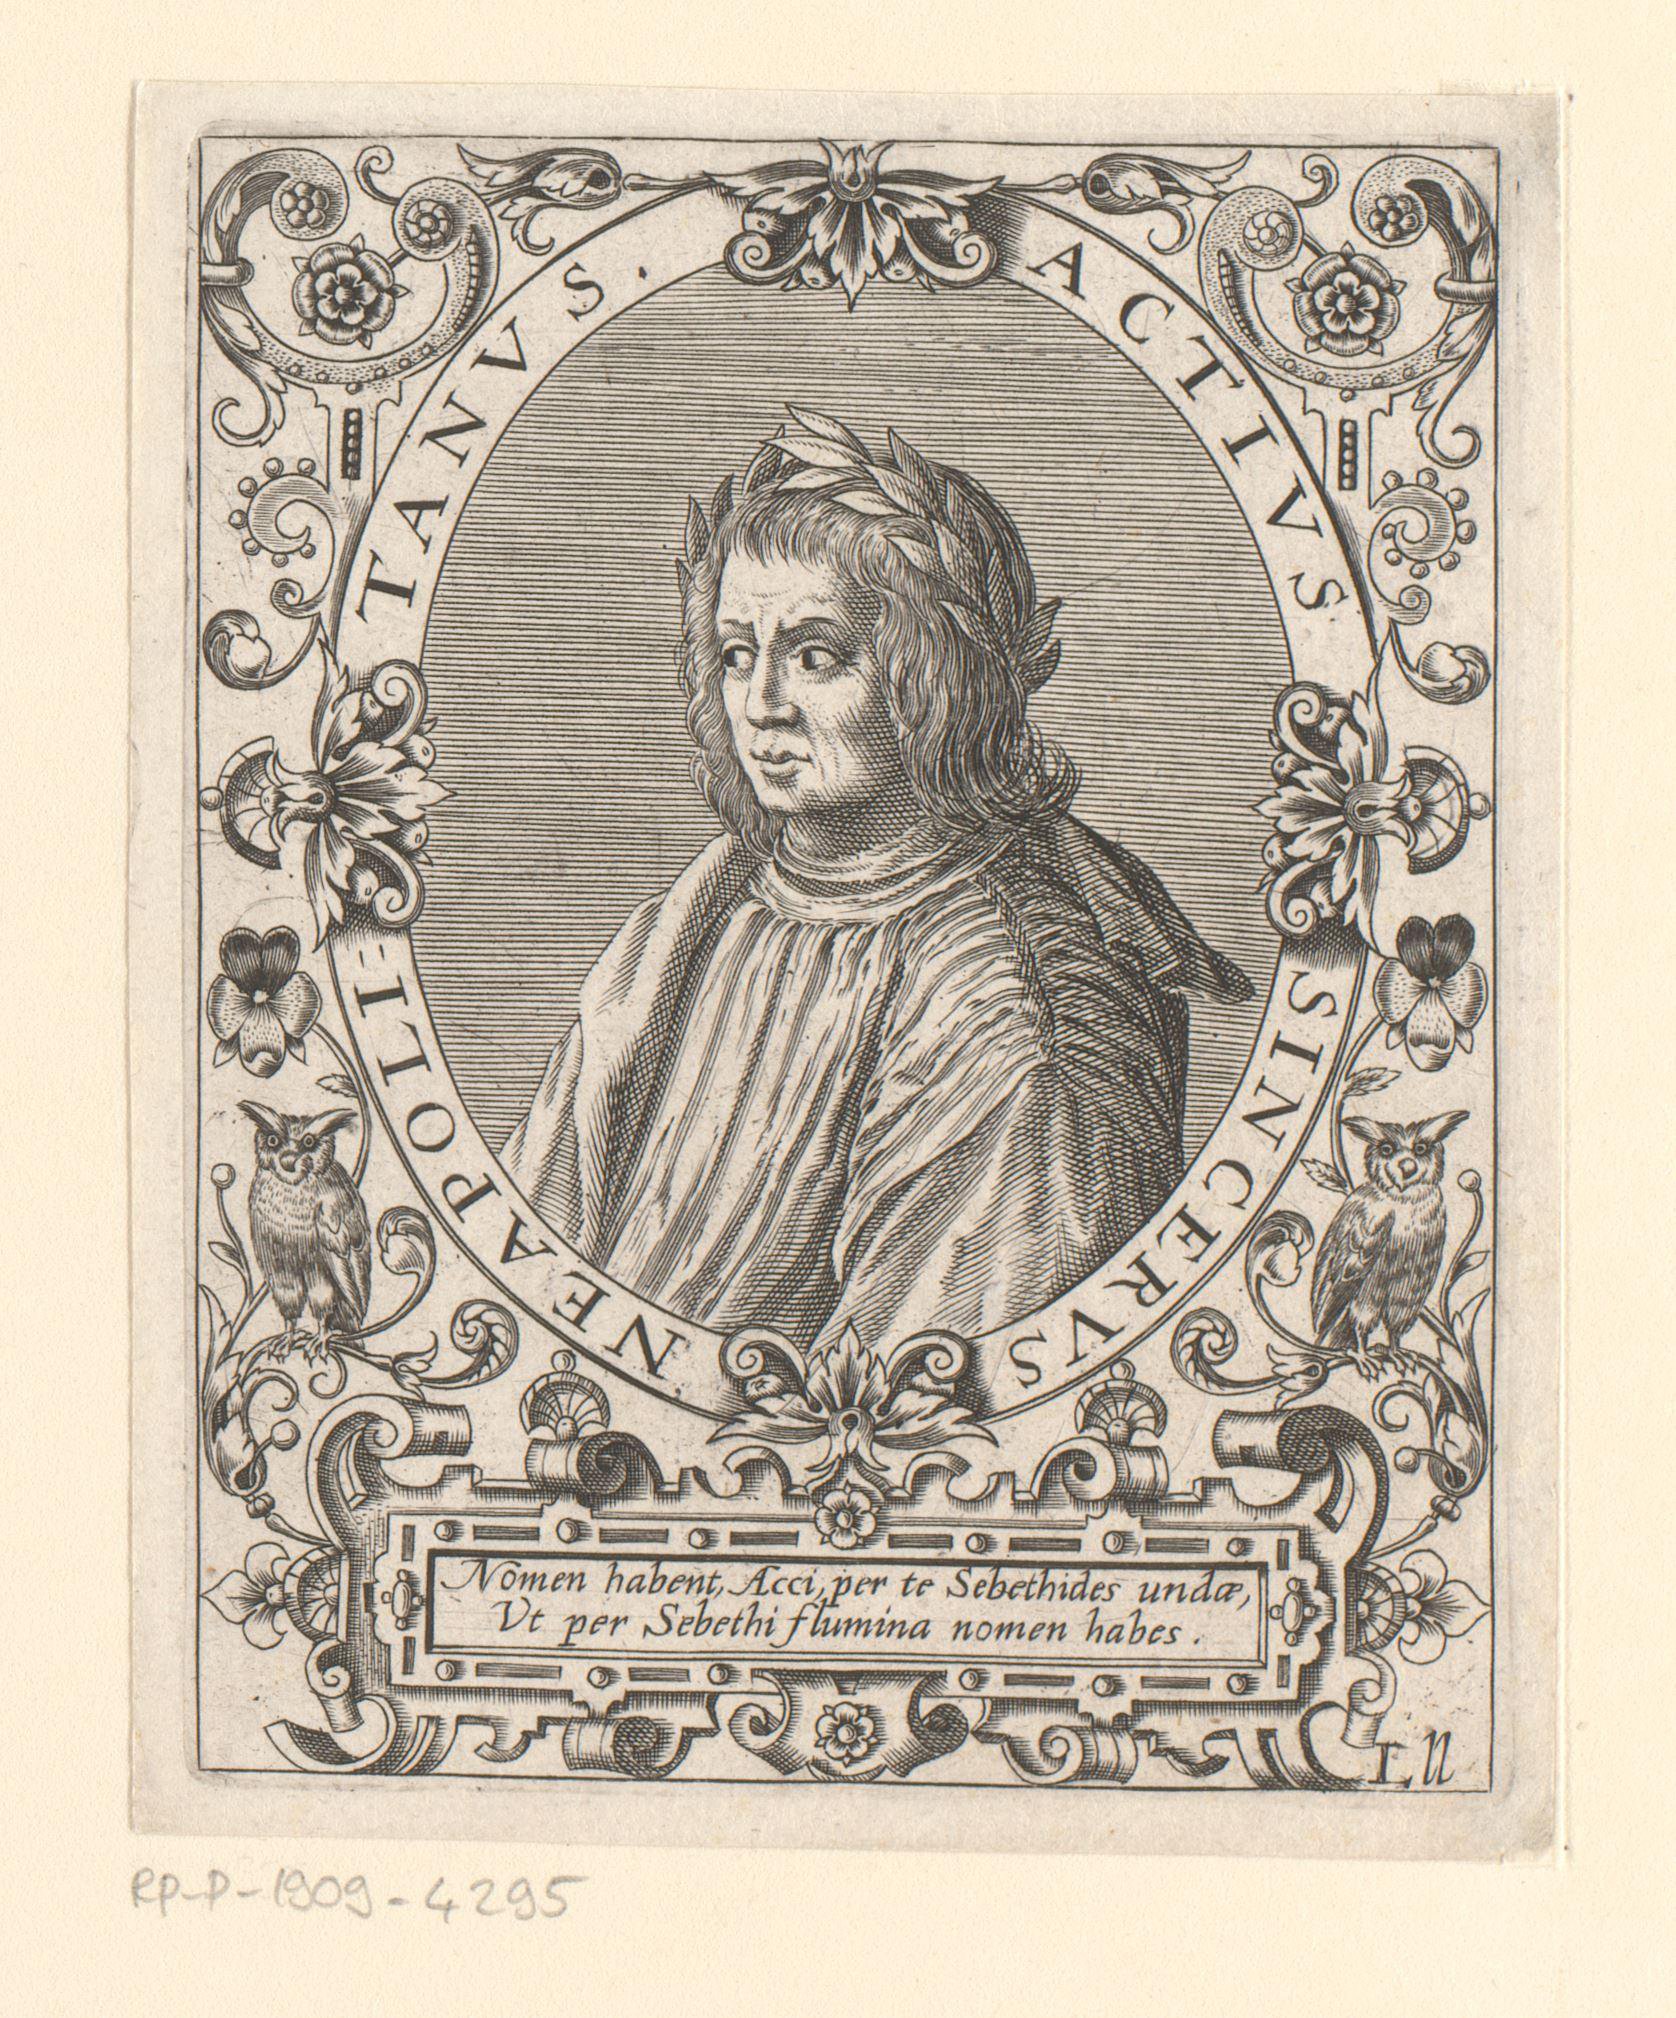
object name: book illustration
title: Actius Sincerus Neapolitanus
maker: jean jacques boissard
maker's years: 1528-1598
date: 1669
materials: paper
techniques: engraving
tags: jacopo sannazaro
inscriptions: collector's mark: Lugt 2228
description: Gemaakt voor: J.J. Boissard, Icones virorum illustrium doctrina &c eruditione praestanti um contines. Frankfurt am Main: de Bry, 1597-1599. Opnieuw gebruikt in: J.J.Boissard, Bibliotheca chalcographica, hoc est Virtute et eruditione clarorum Virorum Imagines. Heidelberg: Clemens Ammon, 1669 (te herkennen aan de toegevoegde signatuur in de rechter onderhoek: 3L).